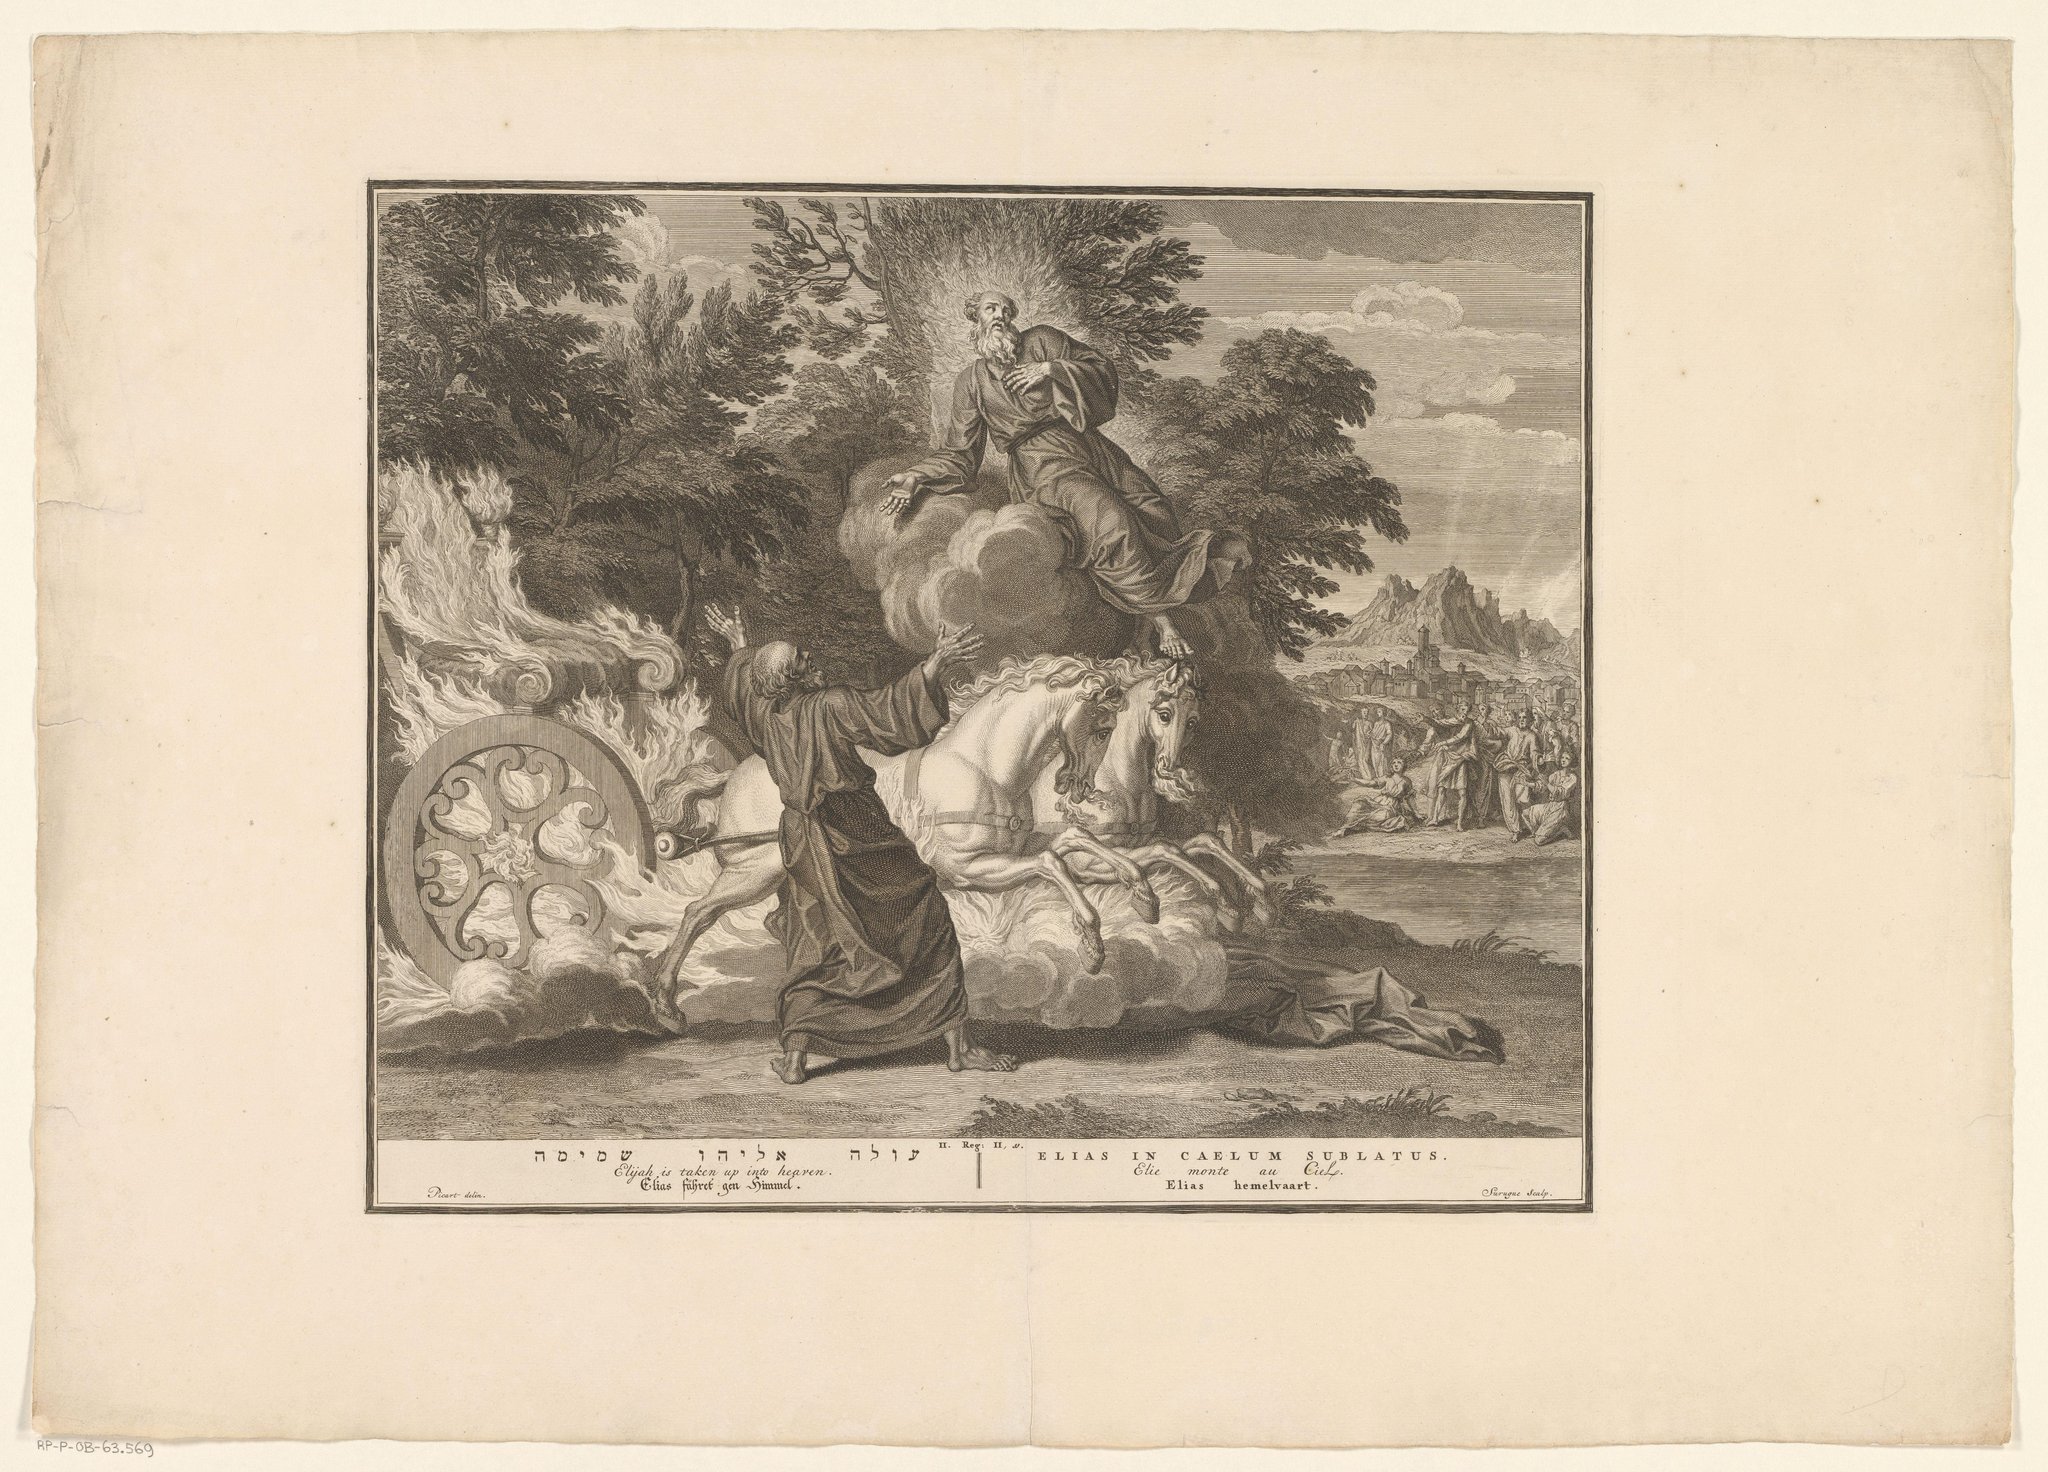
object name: print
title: Elias in caelum sublatus/ Elijah is taken up into heaven (...)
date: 1720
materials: paper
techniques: engraving, etching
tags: a chariot, horses of fire and a whirlwind appear and elijah is carried up into heaven; elijah's cloak falls (or he hands it over to elisha)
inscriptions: collector's mark: Lugt 2228